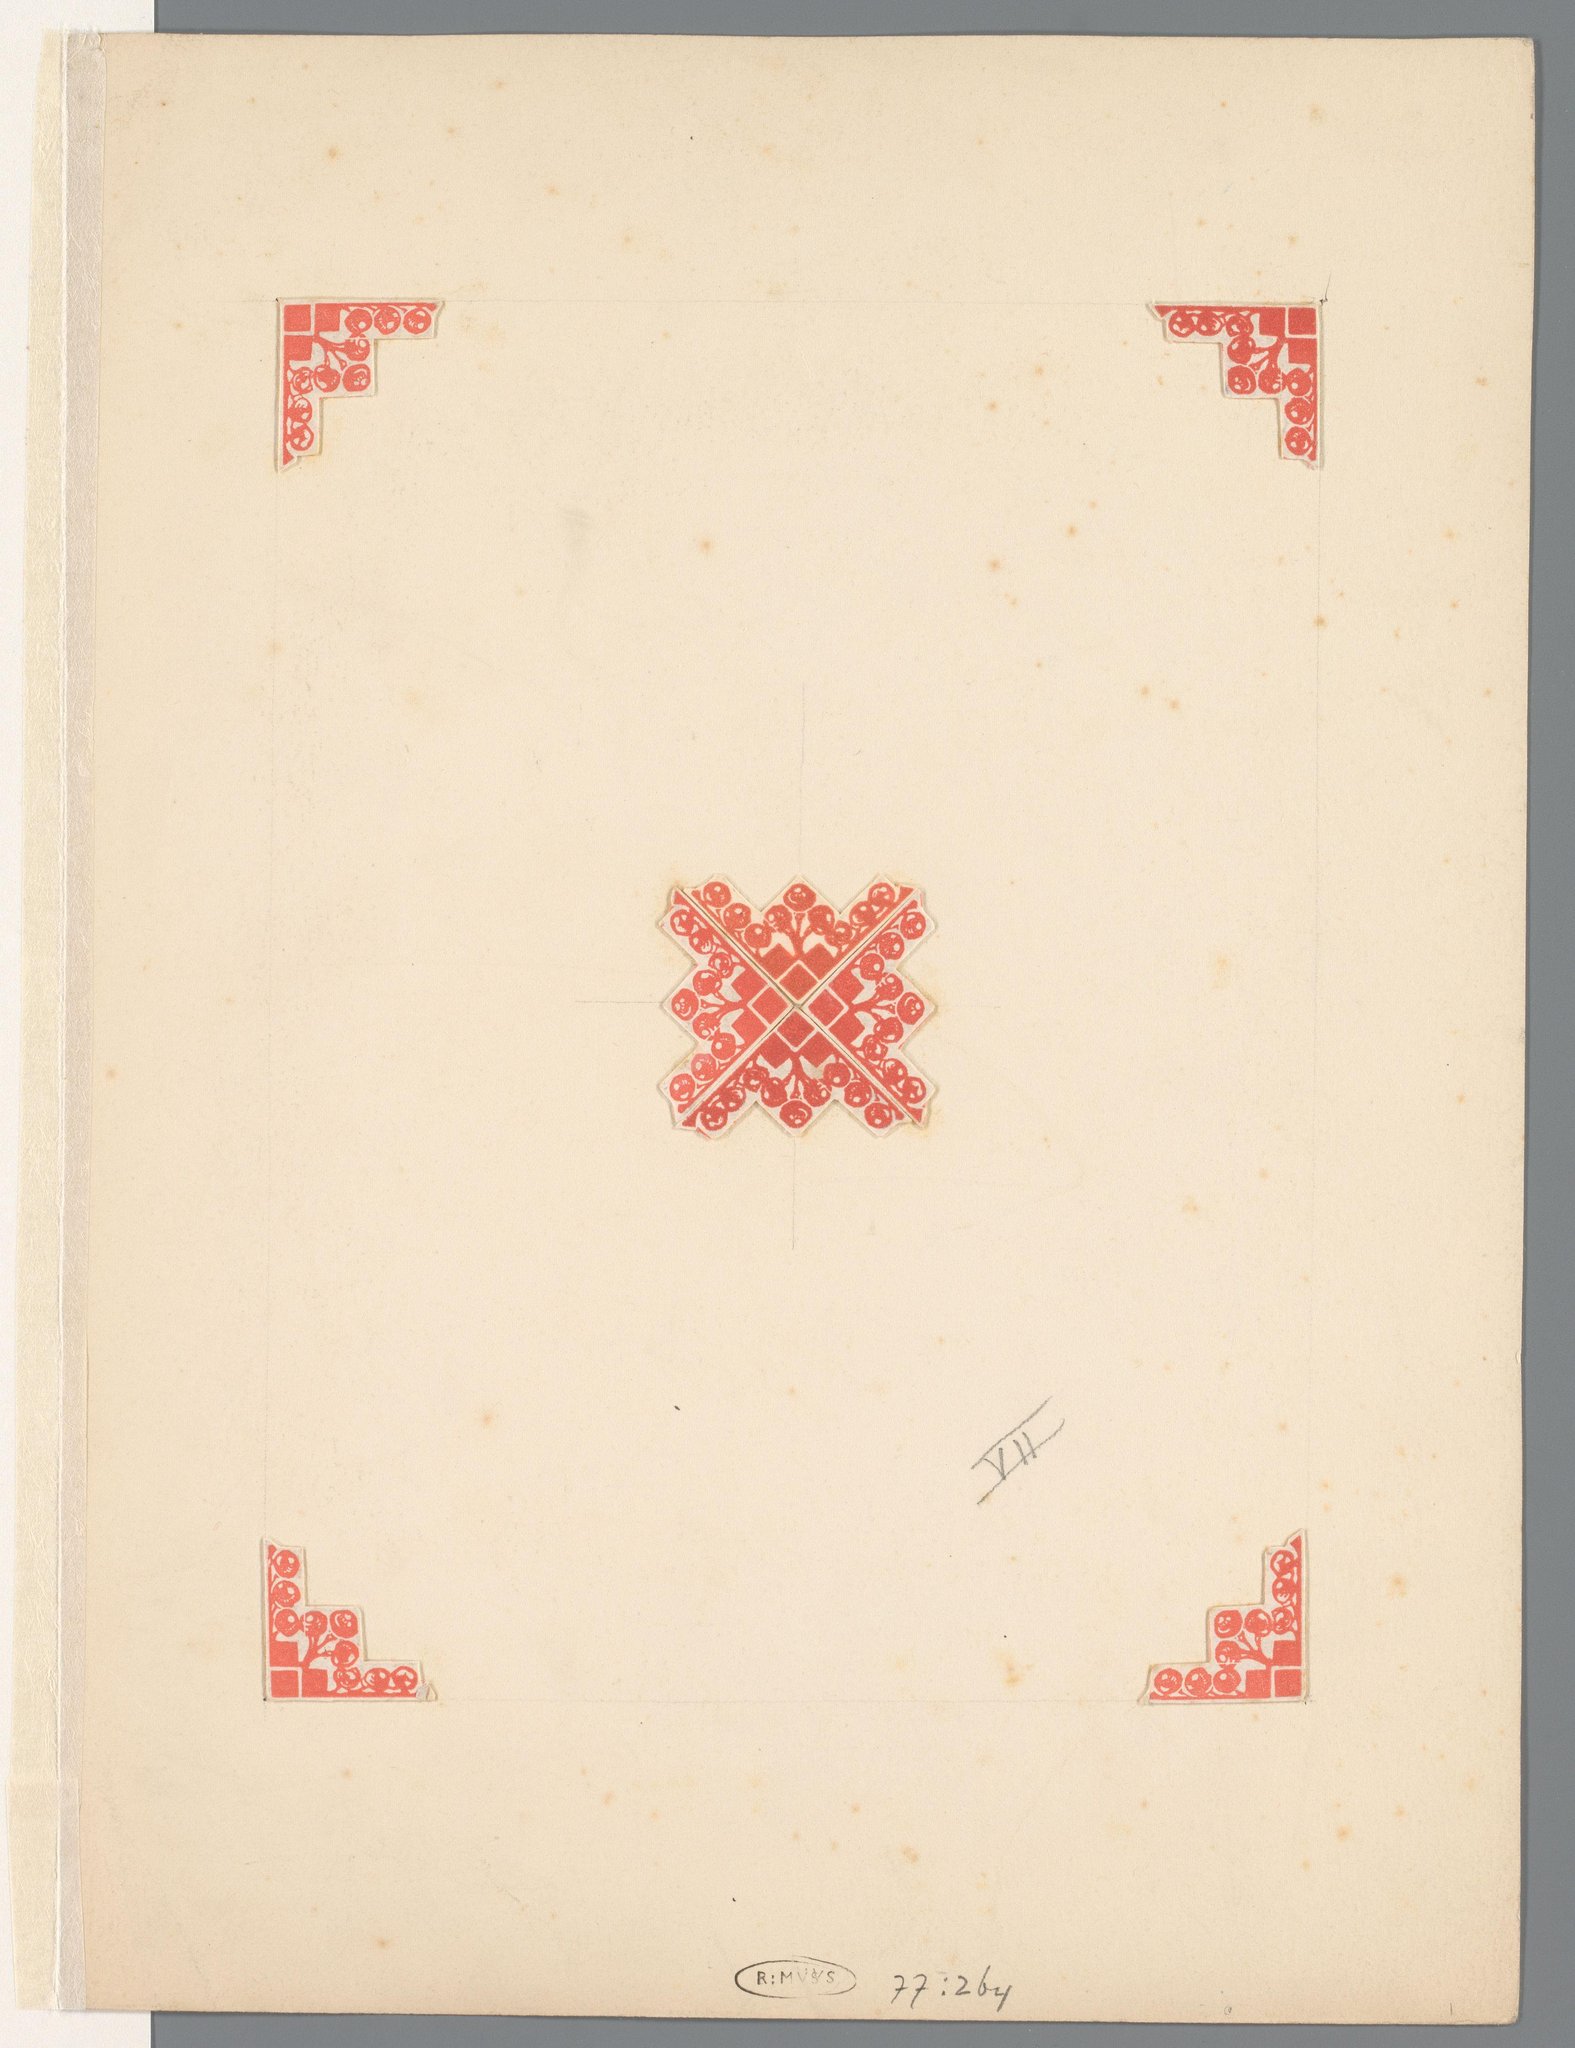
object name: print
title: Ornamentiek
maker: bernard willem wierink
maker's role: draughtsman, print maker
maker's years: 1856-1939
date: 1937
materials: paper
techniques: relief print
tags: ornaments ~ art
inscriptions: collector's mark: Lugt 2228, annotation: ‘op één na. laatste correctie’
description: Deze prent is vermoedelijk een plaatsnede, ook al wordt in de literatuur veelal gesproken over een houtsnede. Voor zover Wierink zijn prenten in hoogdruk zelf nader heeft omschreven, heeft hij altijd de term 'plaatsnede' gebruikt.